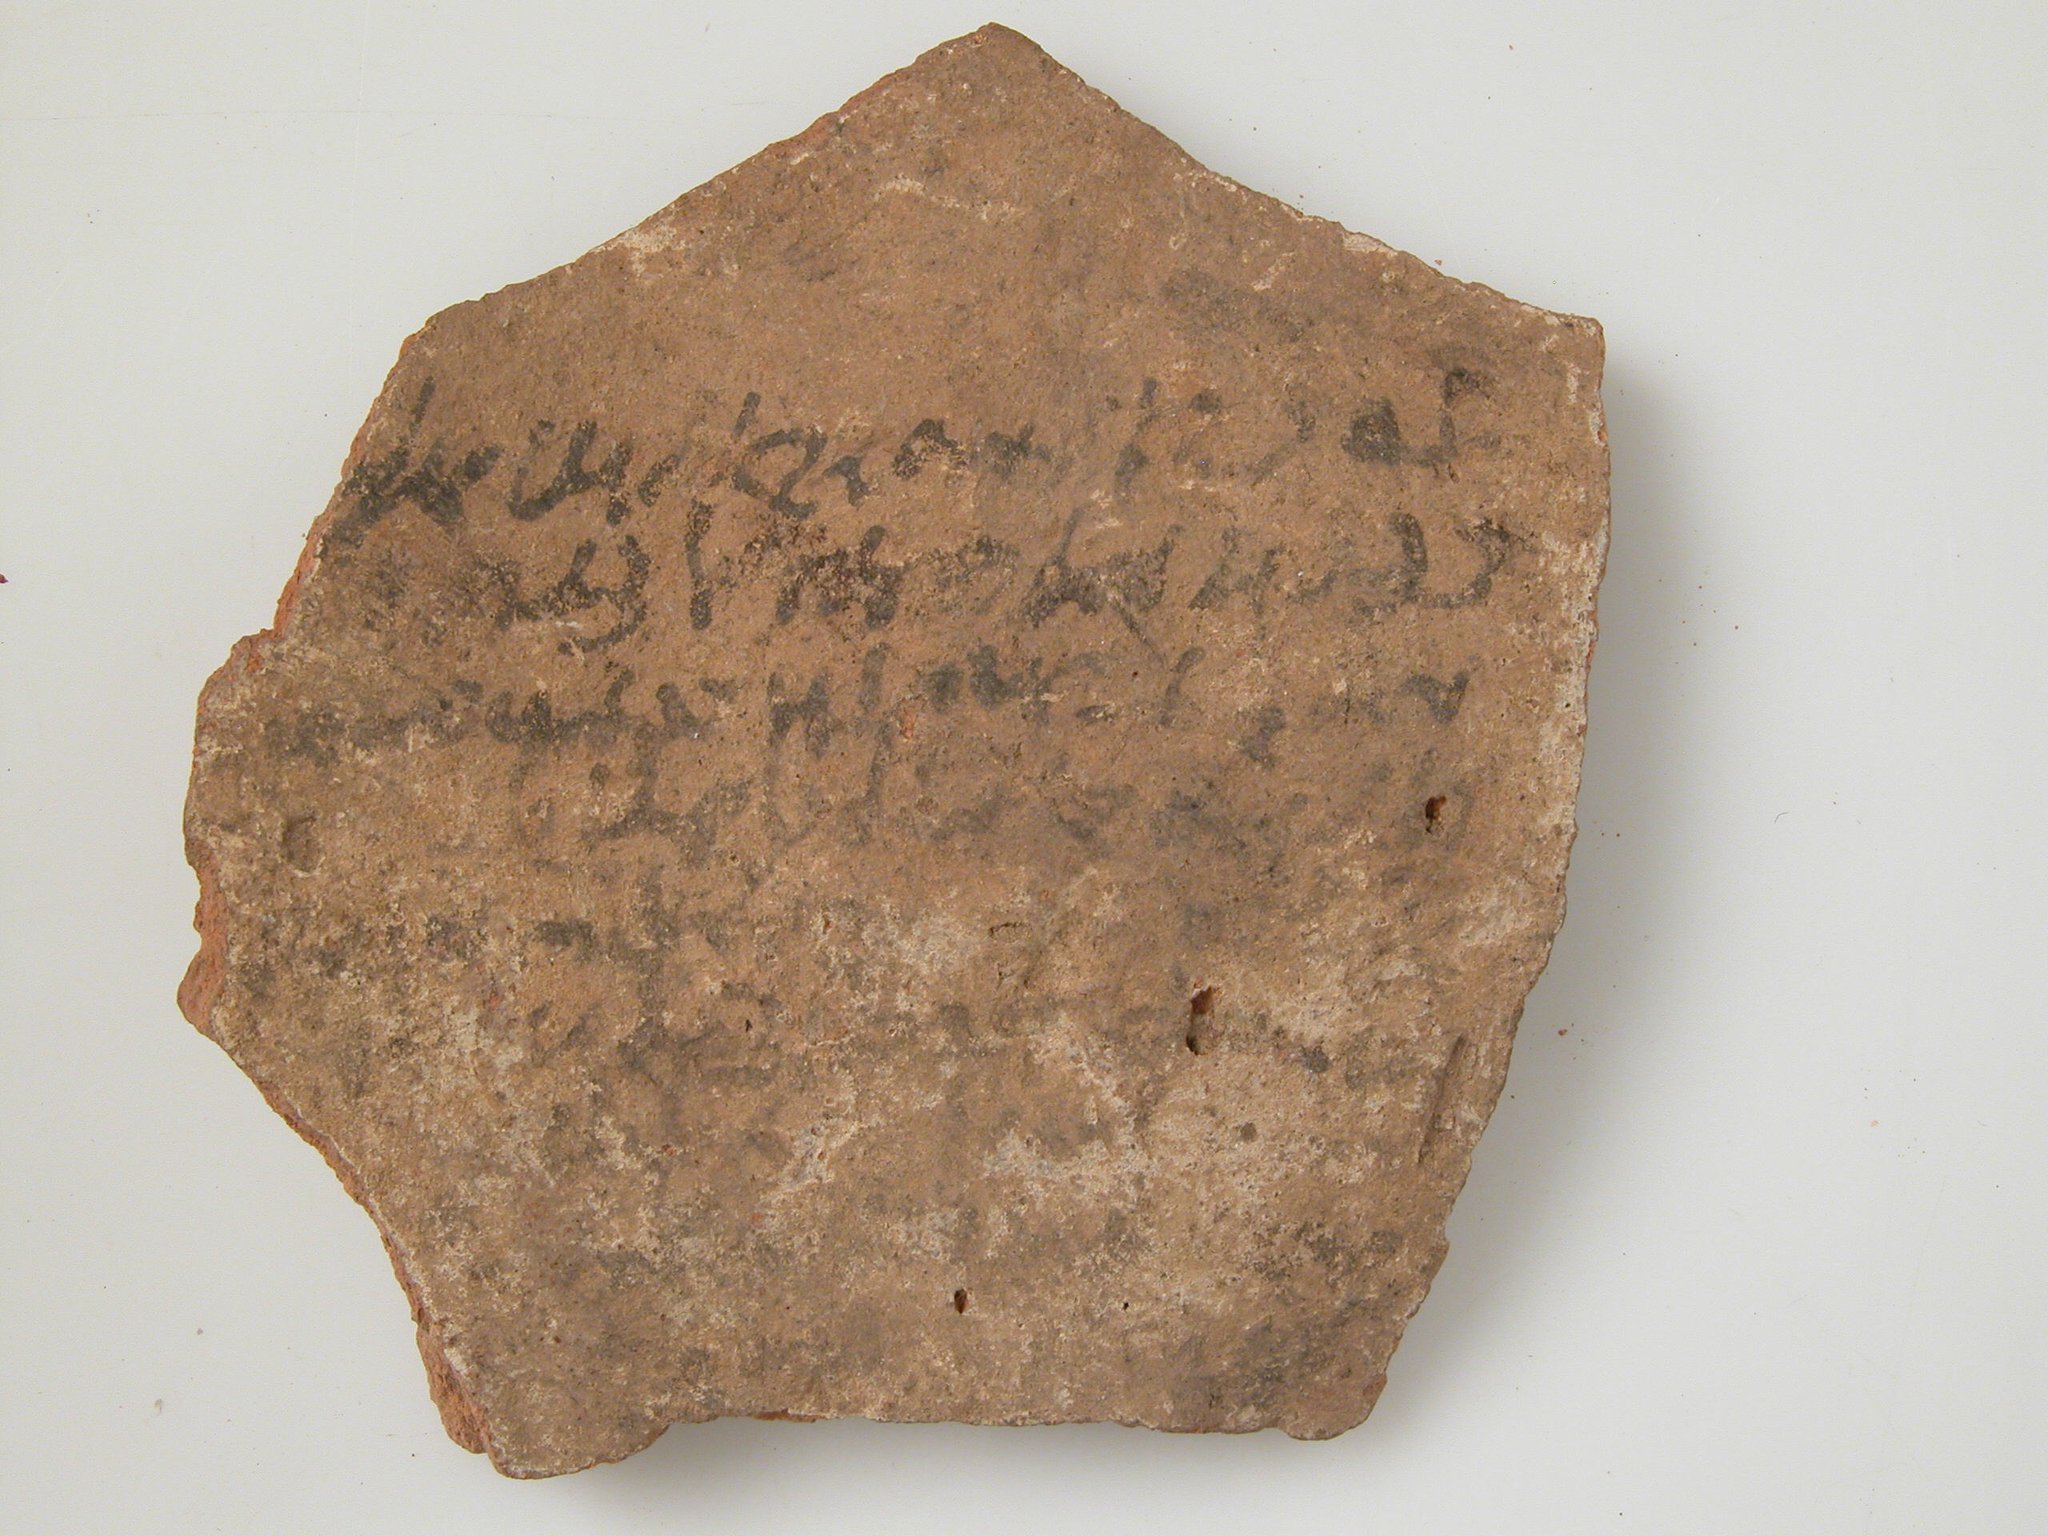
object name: ostrakon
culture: coptic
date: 301-700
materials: ink, pottery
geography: egypt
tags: documents